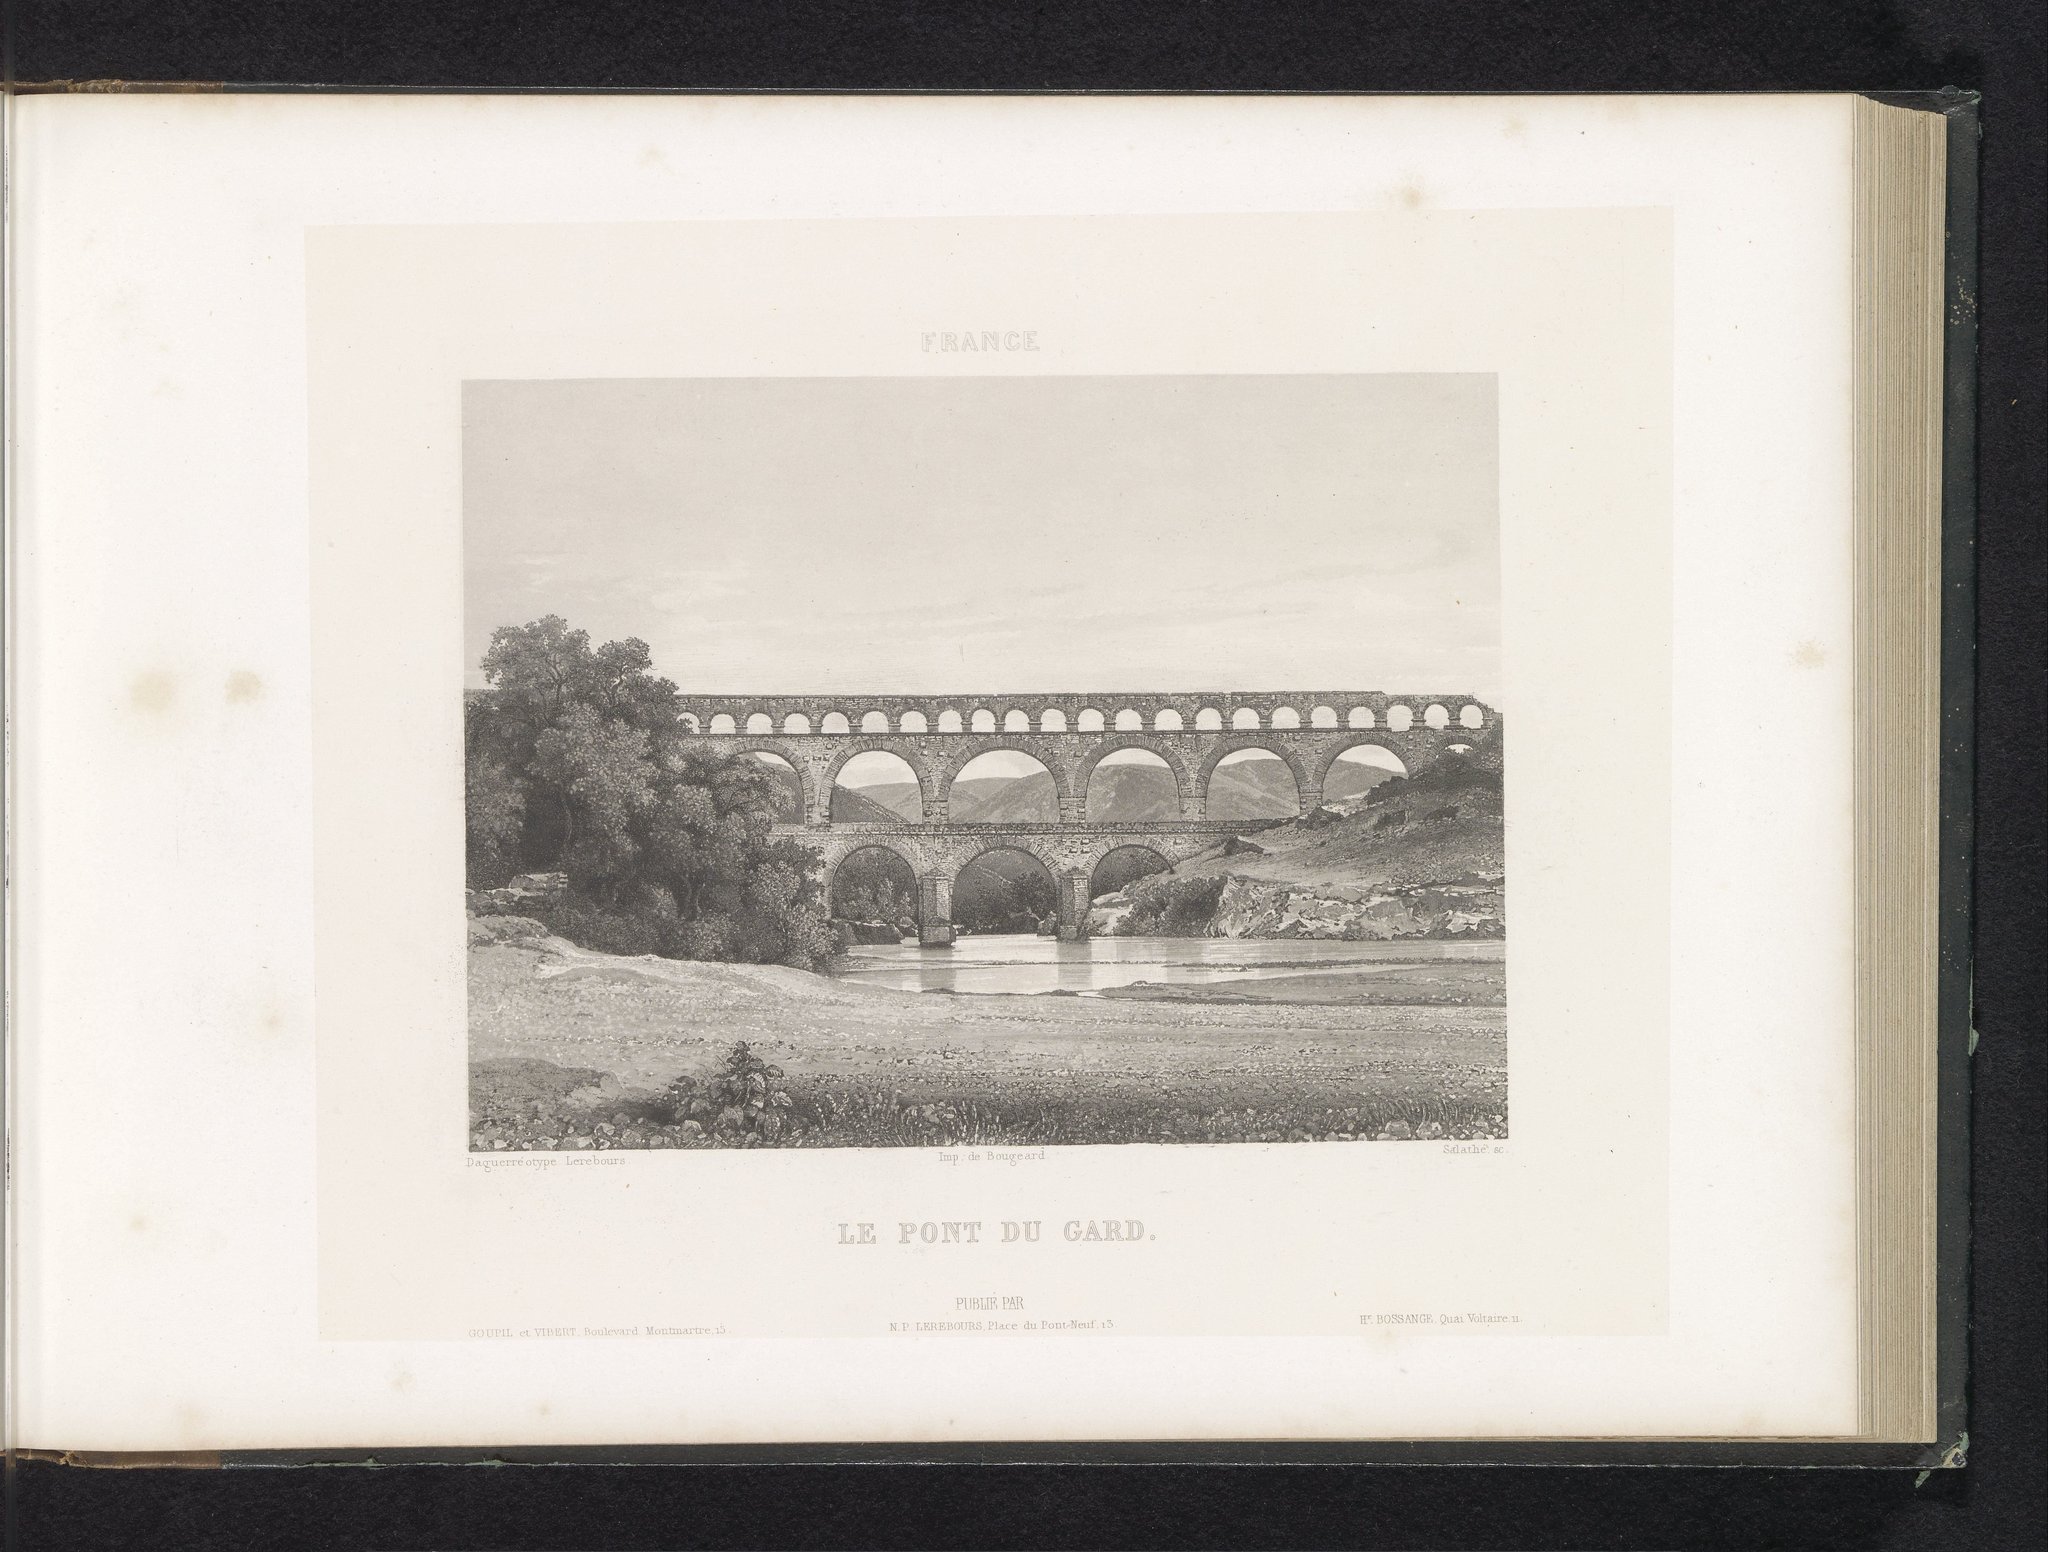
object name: print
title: Le Pont du Gard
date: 1839-1841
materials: paper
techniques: aquatint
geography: paris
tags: landscape with bridge, viaduct or aqueduct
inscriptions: inscription: ‘N.P. Lerebours Place du Pont Neuf 15’, inscription: ‘Hr. Bossance Quai Voltaire 11’, inscription: ‘Rittner & Goupil Boulevd Montmartre 15’